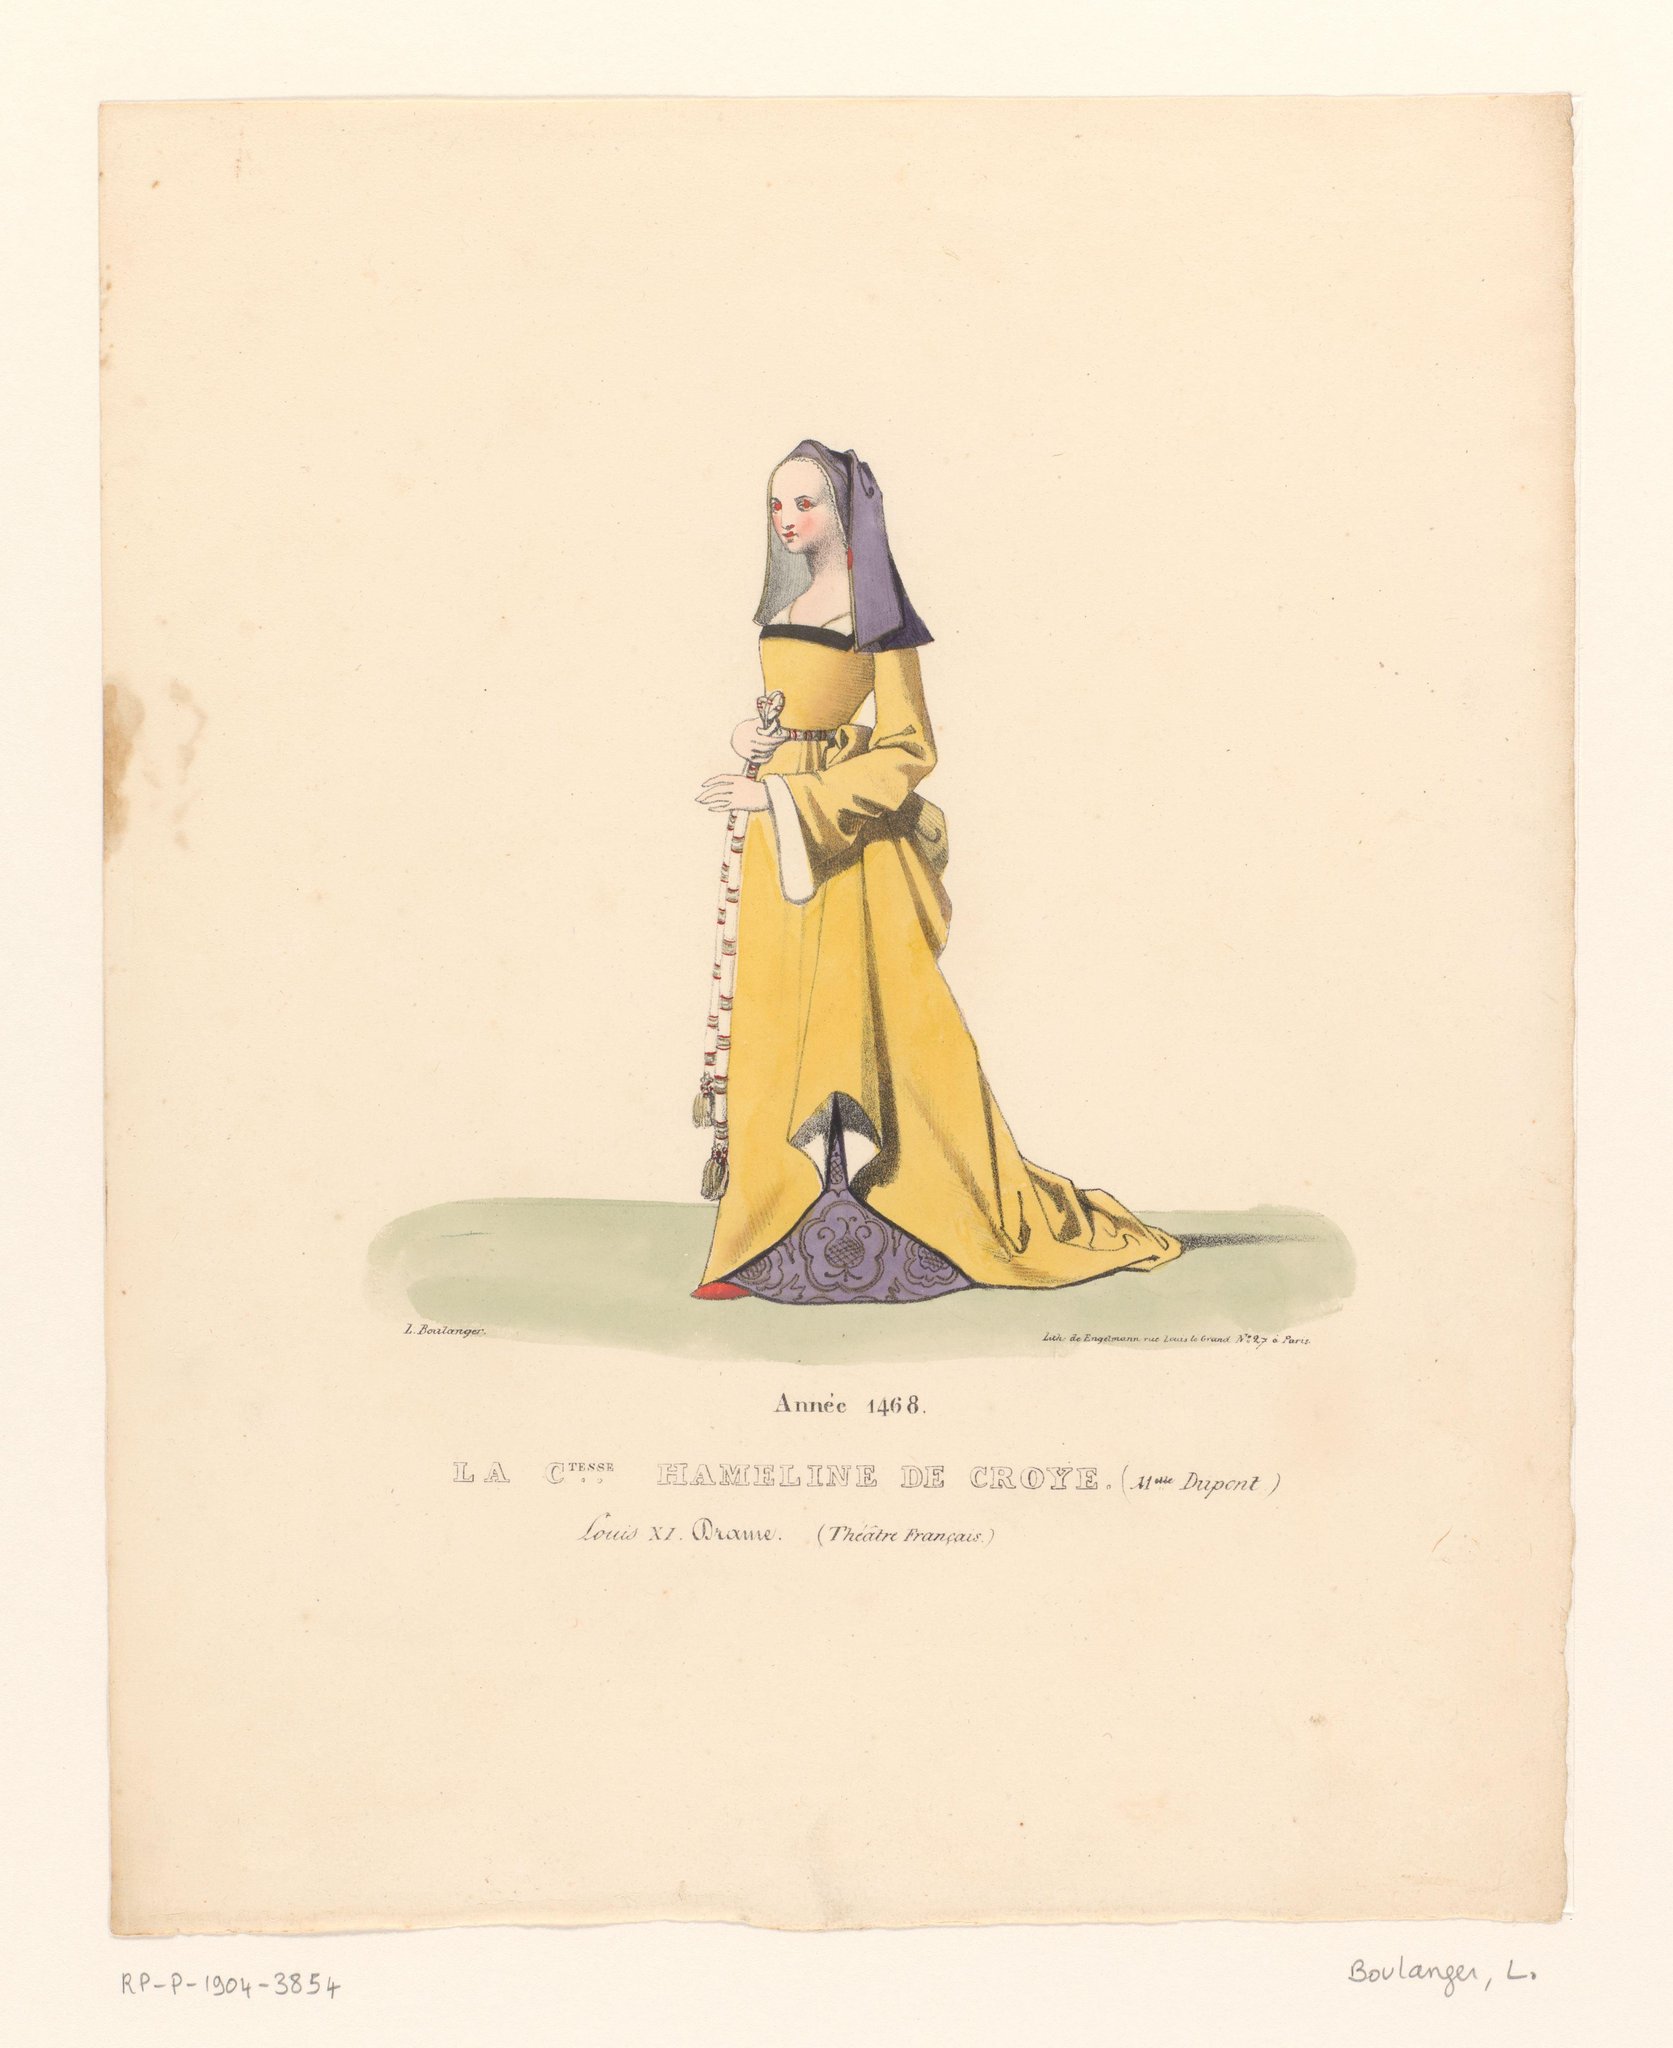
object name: print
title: Theaterkostuums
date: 1826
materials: paper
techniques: hand coloring, lithograph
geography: paris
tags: stage costume, actor (on the stage), tragedy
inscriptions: collector's mark: Lugt 2228a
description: Gravin Hameline de Croye is een personage uit 'Quentin Durward' van Sir Walter Scott, het boek waar het toneelstuk 'Louis XI à Péronne' op is gebaseerd.